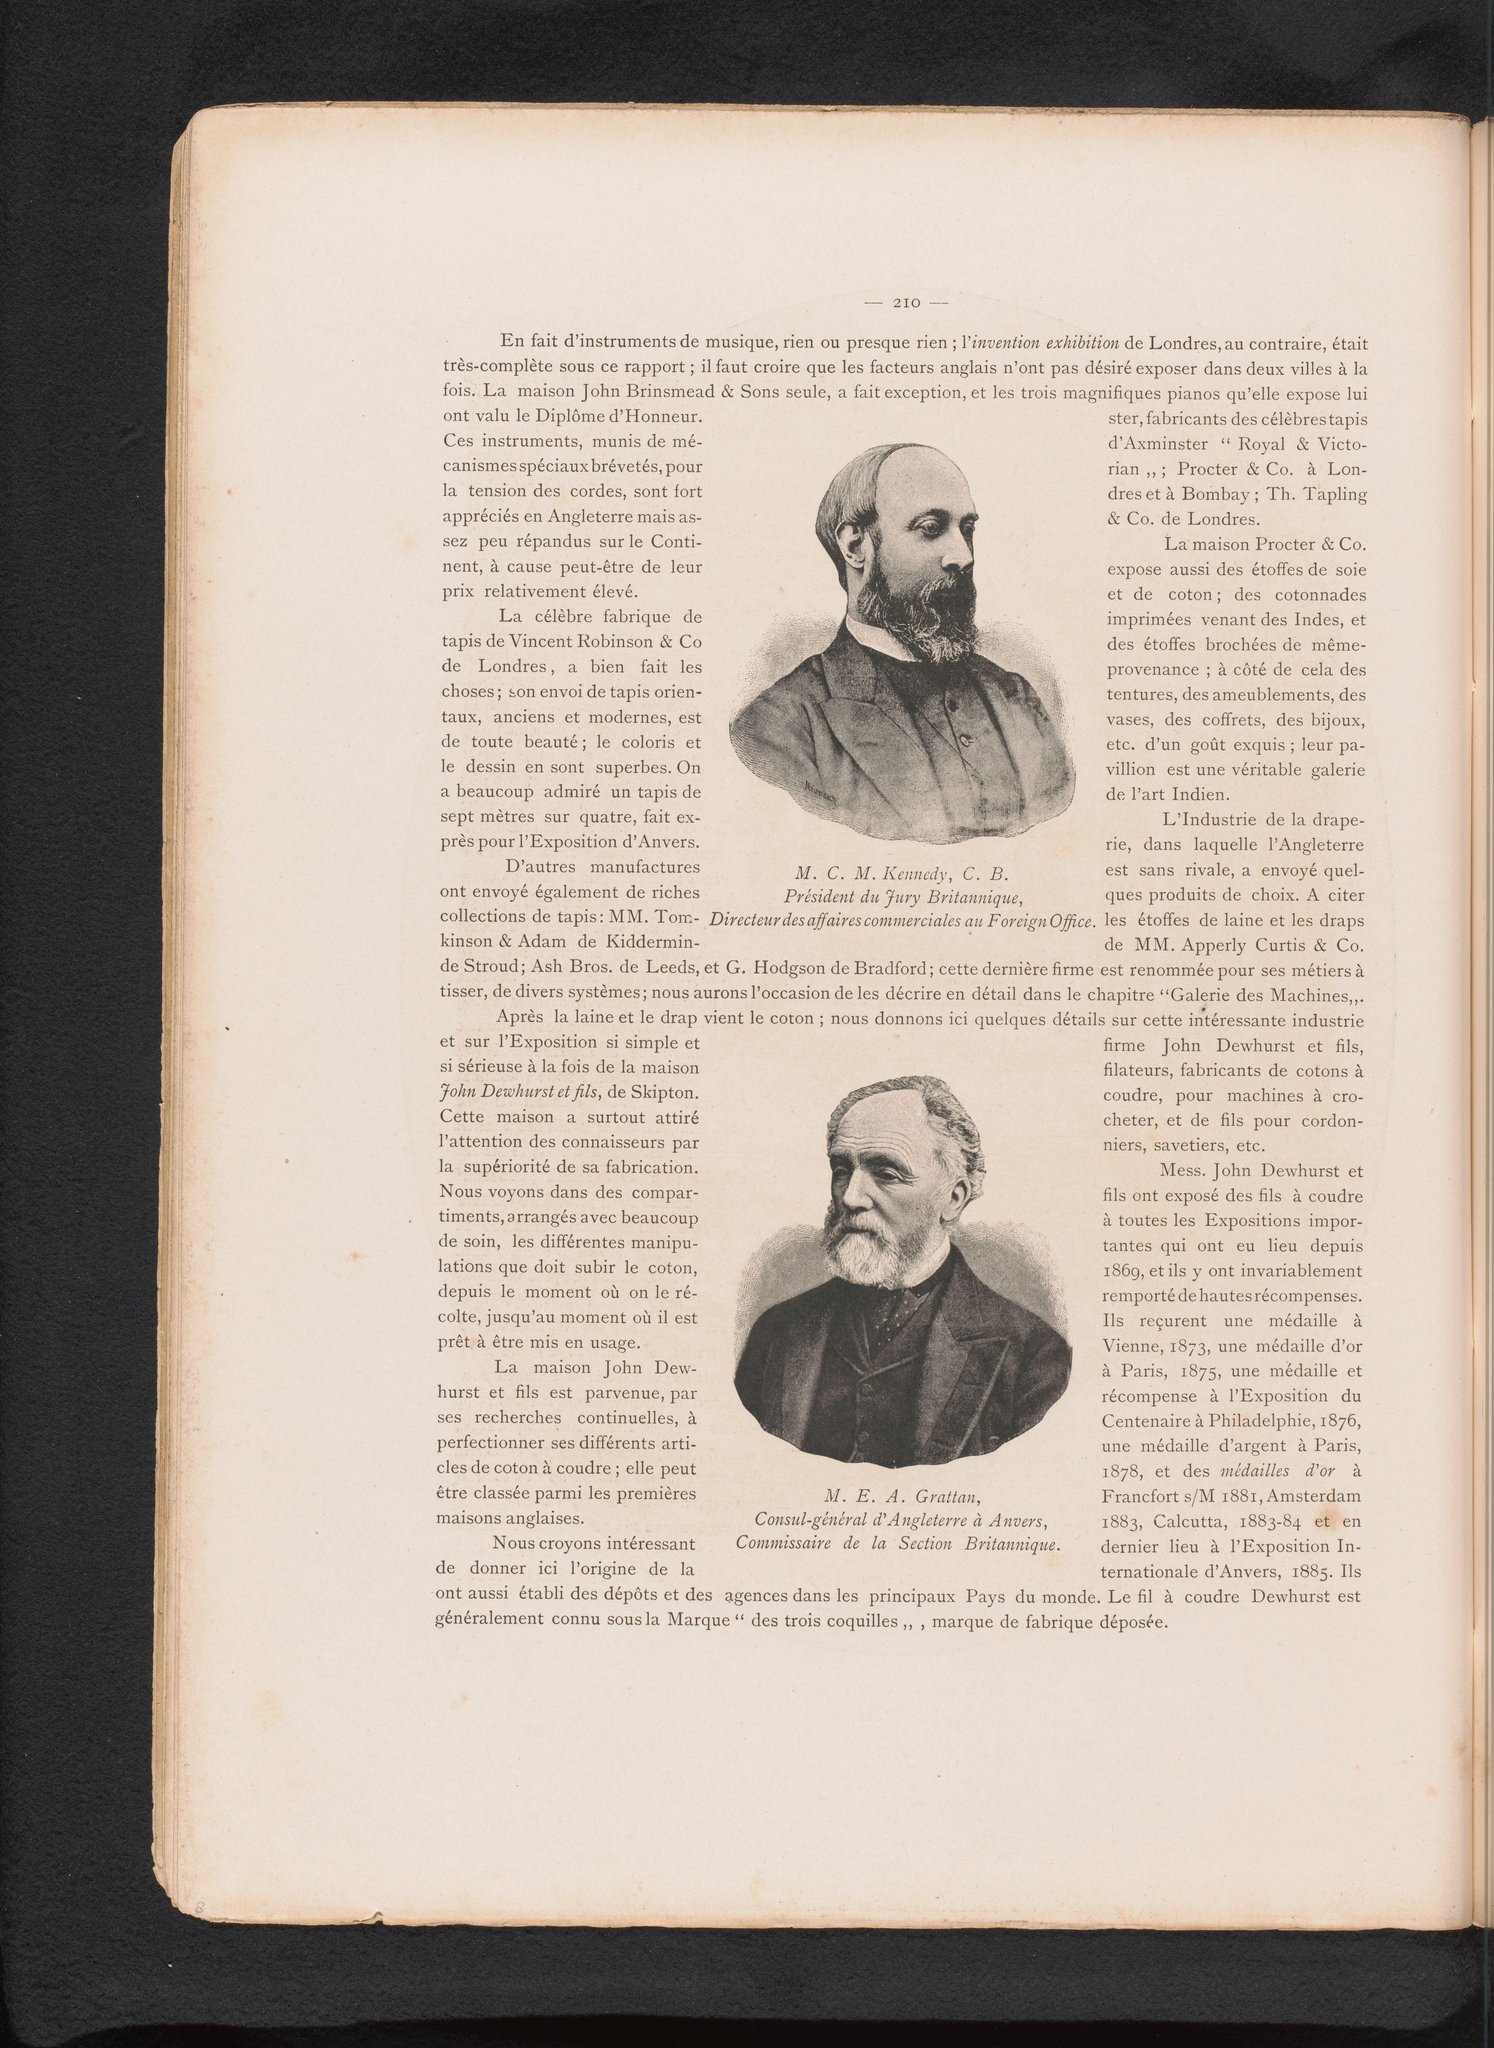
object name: page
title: M. C. M. Kennedy, C. B. Président du Jury Britannique, Directeur des affaires commerciales au Foreign Office.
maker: Anonymous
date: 1880-1885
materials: paper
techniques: autotype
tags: historical persons